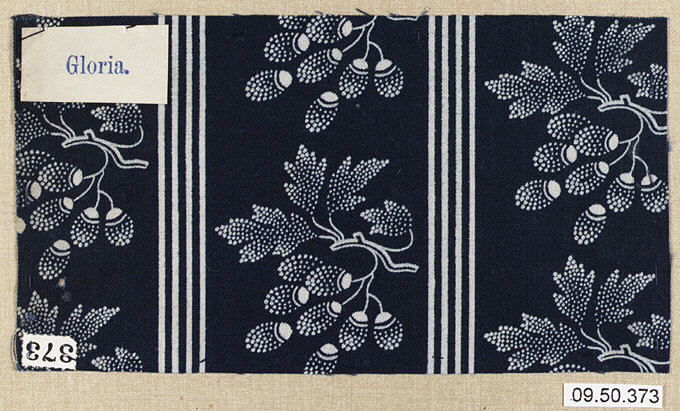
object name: piece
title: Piece (one of 116)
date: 1801-1900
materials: cotton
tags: leaves